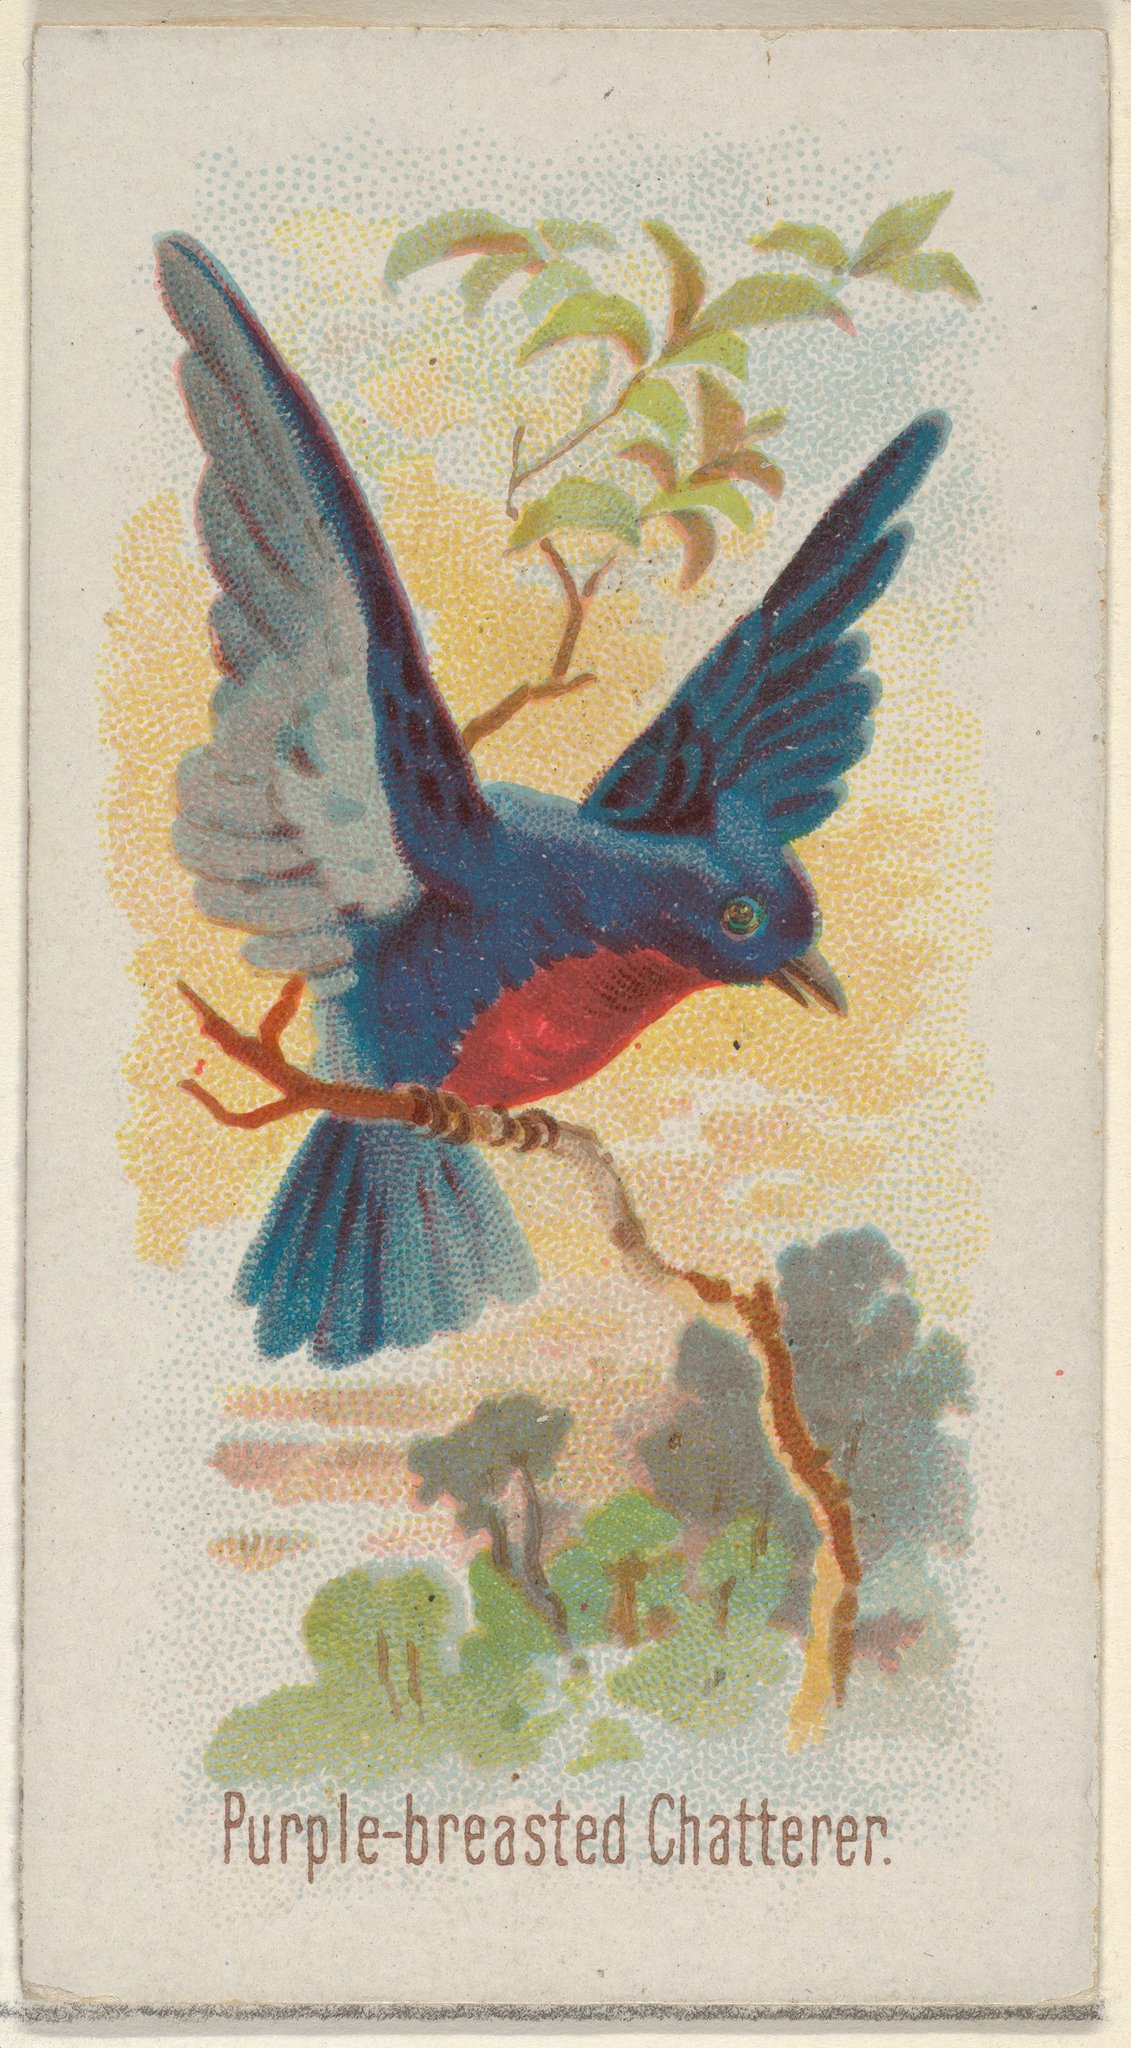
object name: print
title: Purple-breasted Chatterer, from the Song Birds of the World series (N23) for Allen & Ginter Cigarettes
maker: allen & ginter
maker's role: publisher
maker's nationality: american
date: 1890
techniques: color lithograph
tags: birds